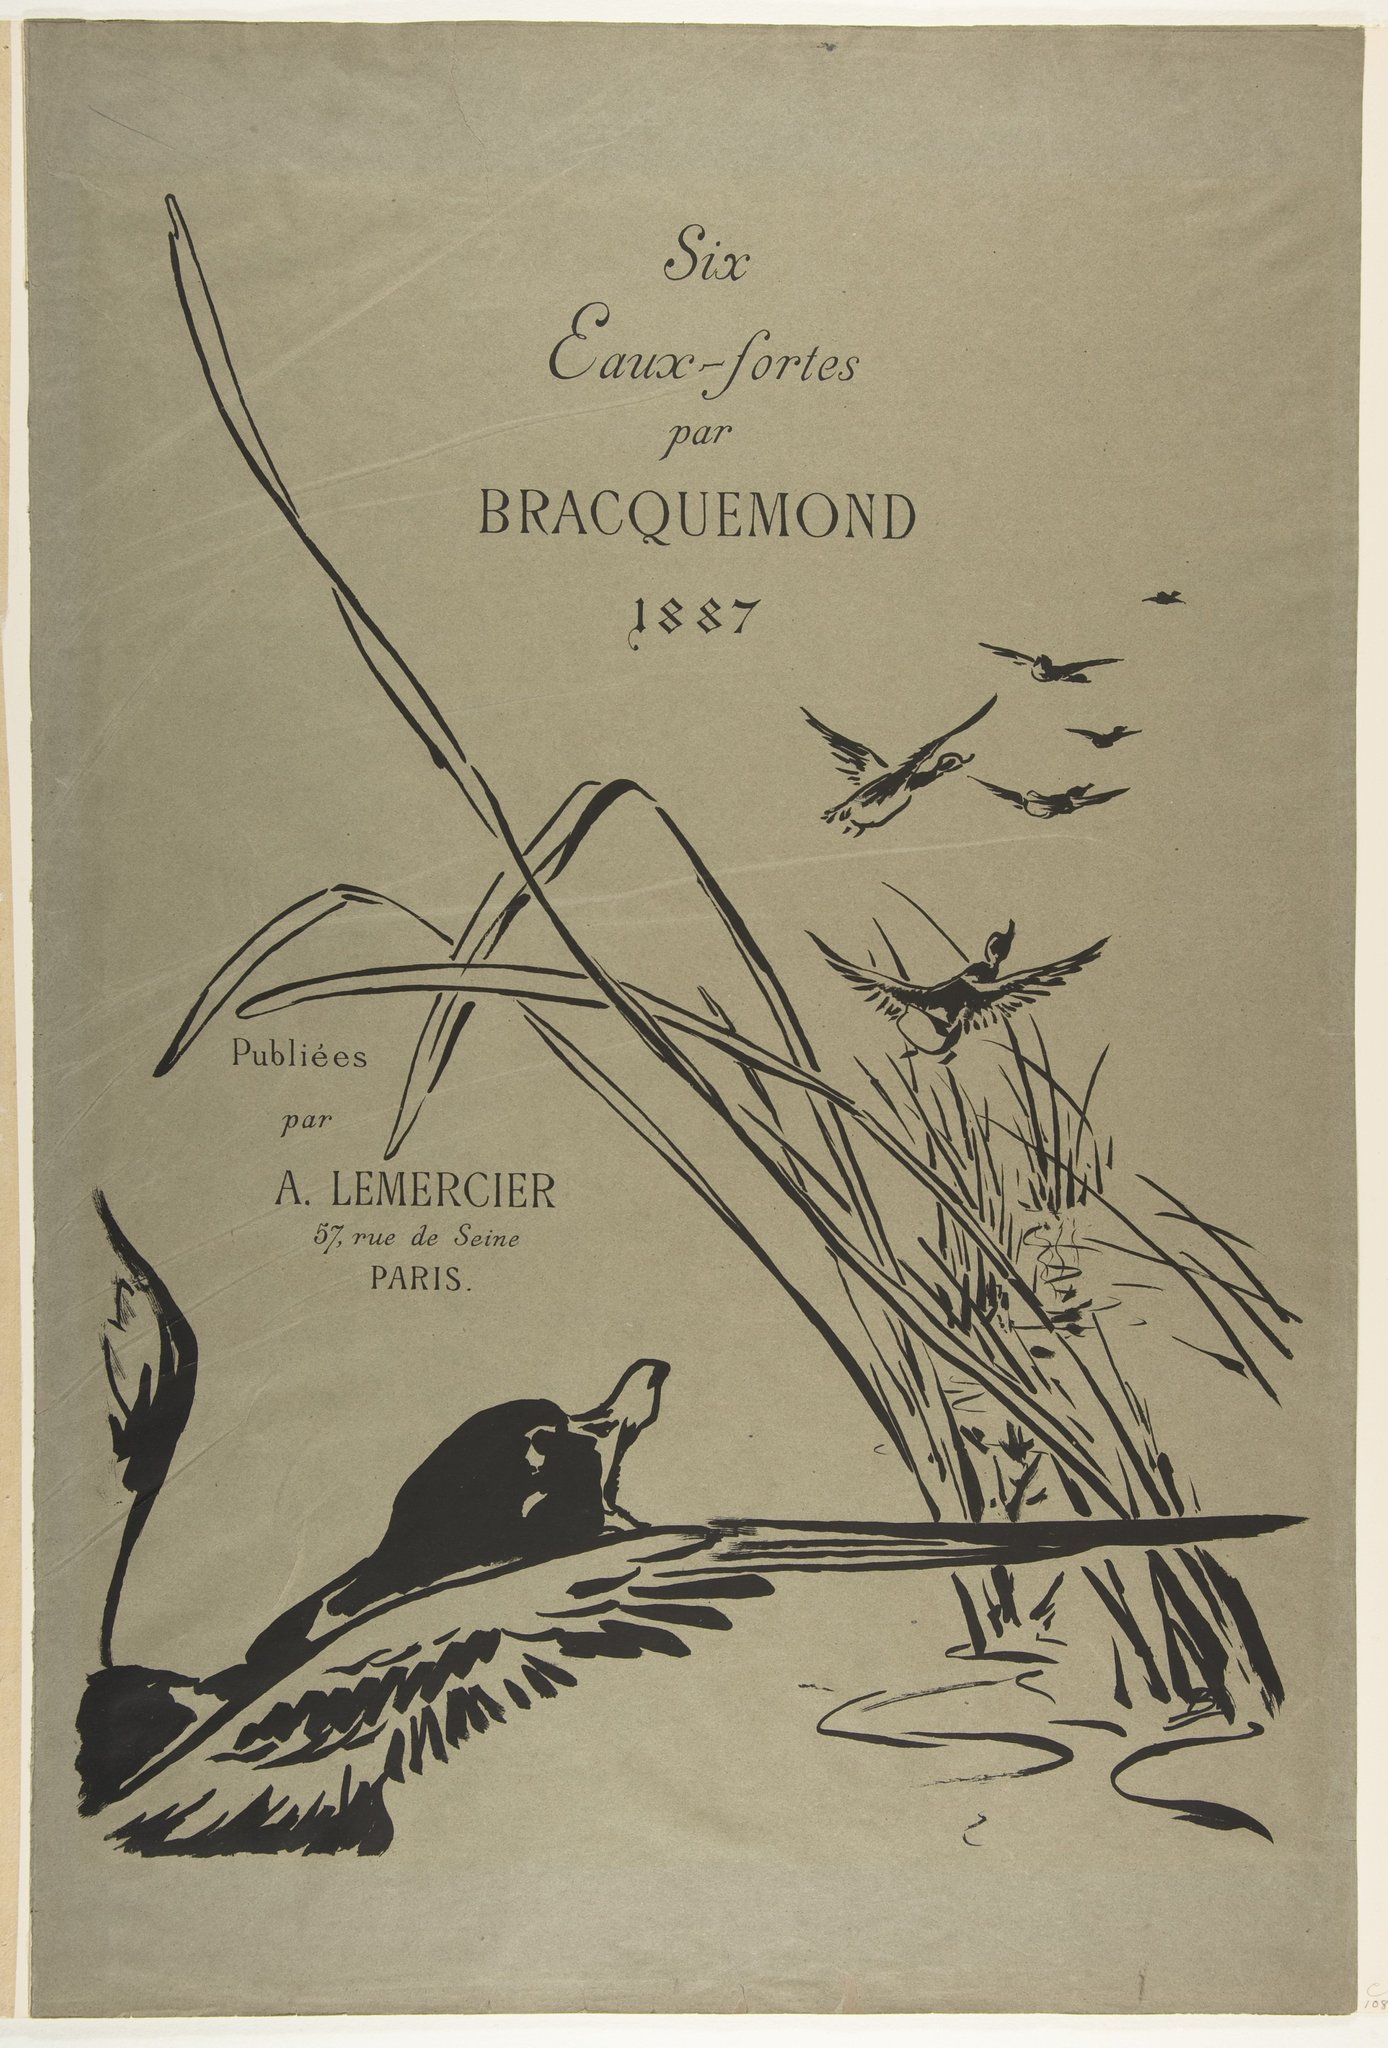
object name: print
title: Six Eaux-fortes par Bracquemond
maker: félix bracquemond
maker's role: artist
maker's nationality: french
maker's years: 1833-1914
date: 1887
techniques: lithograph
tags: birds